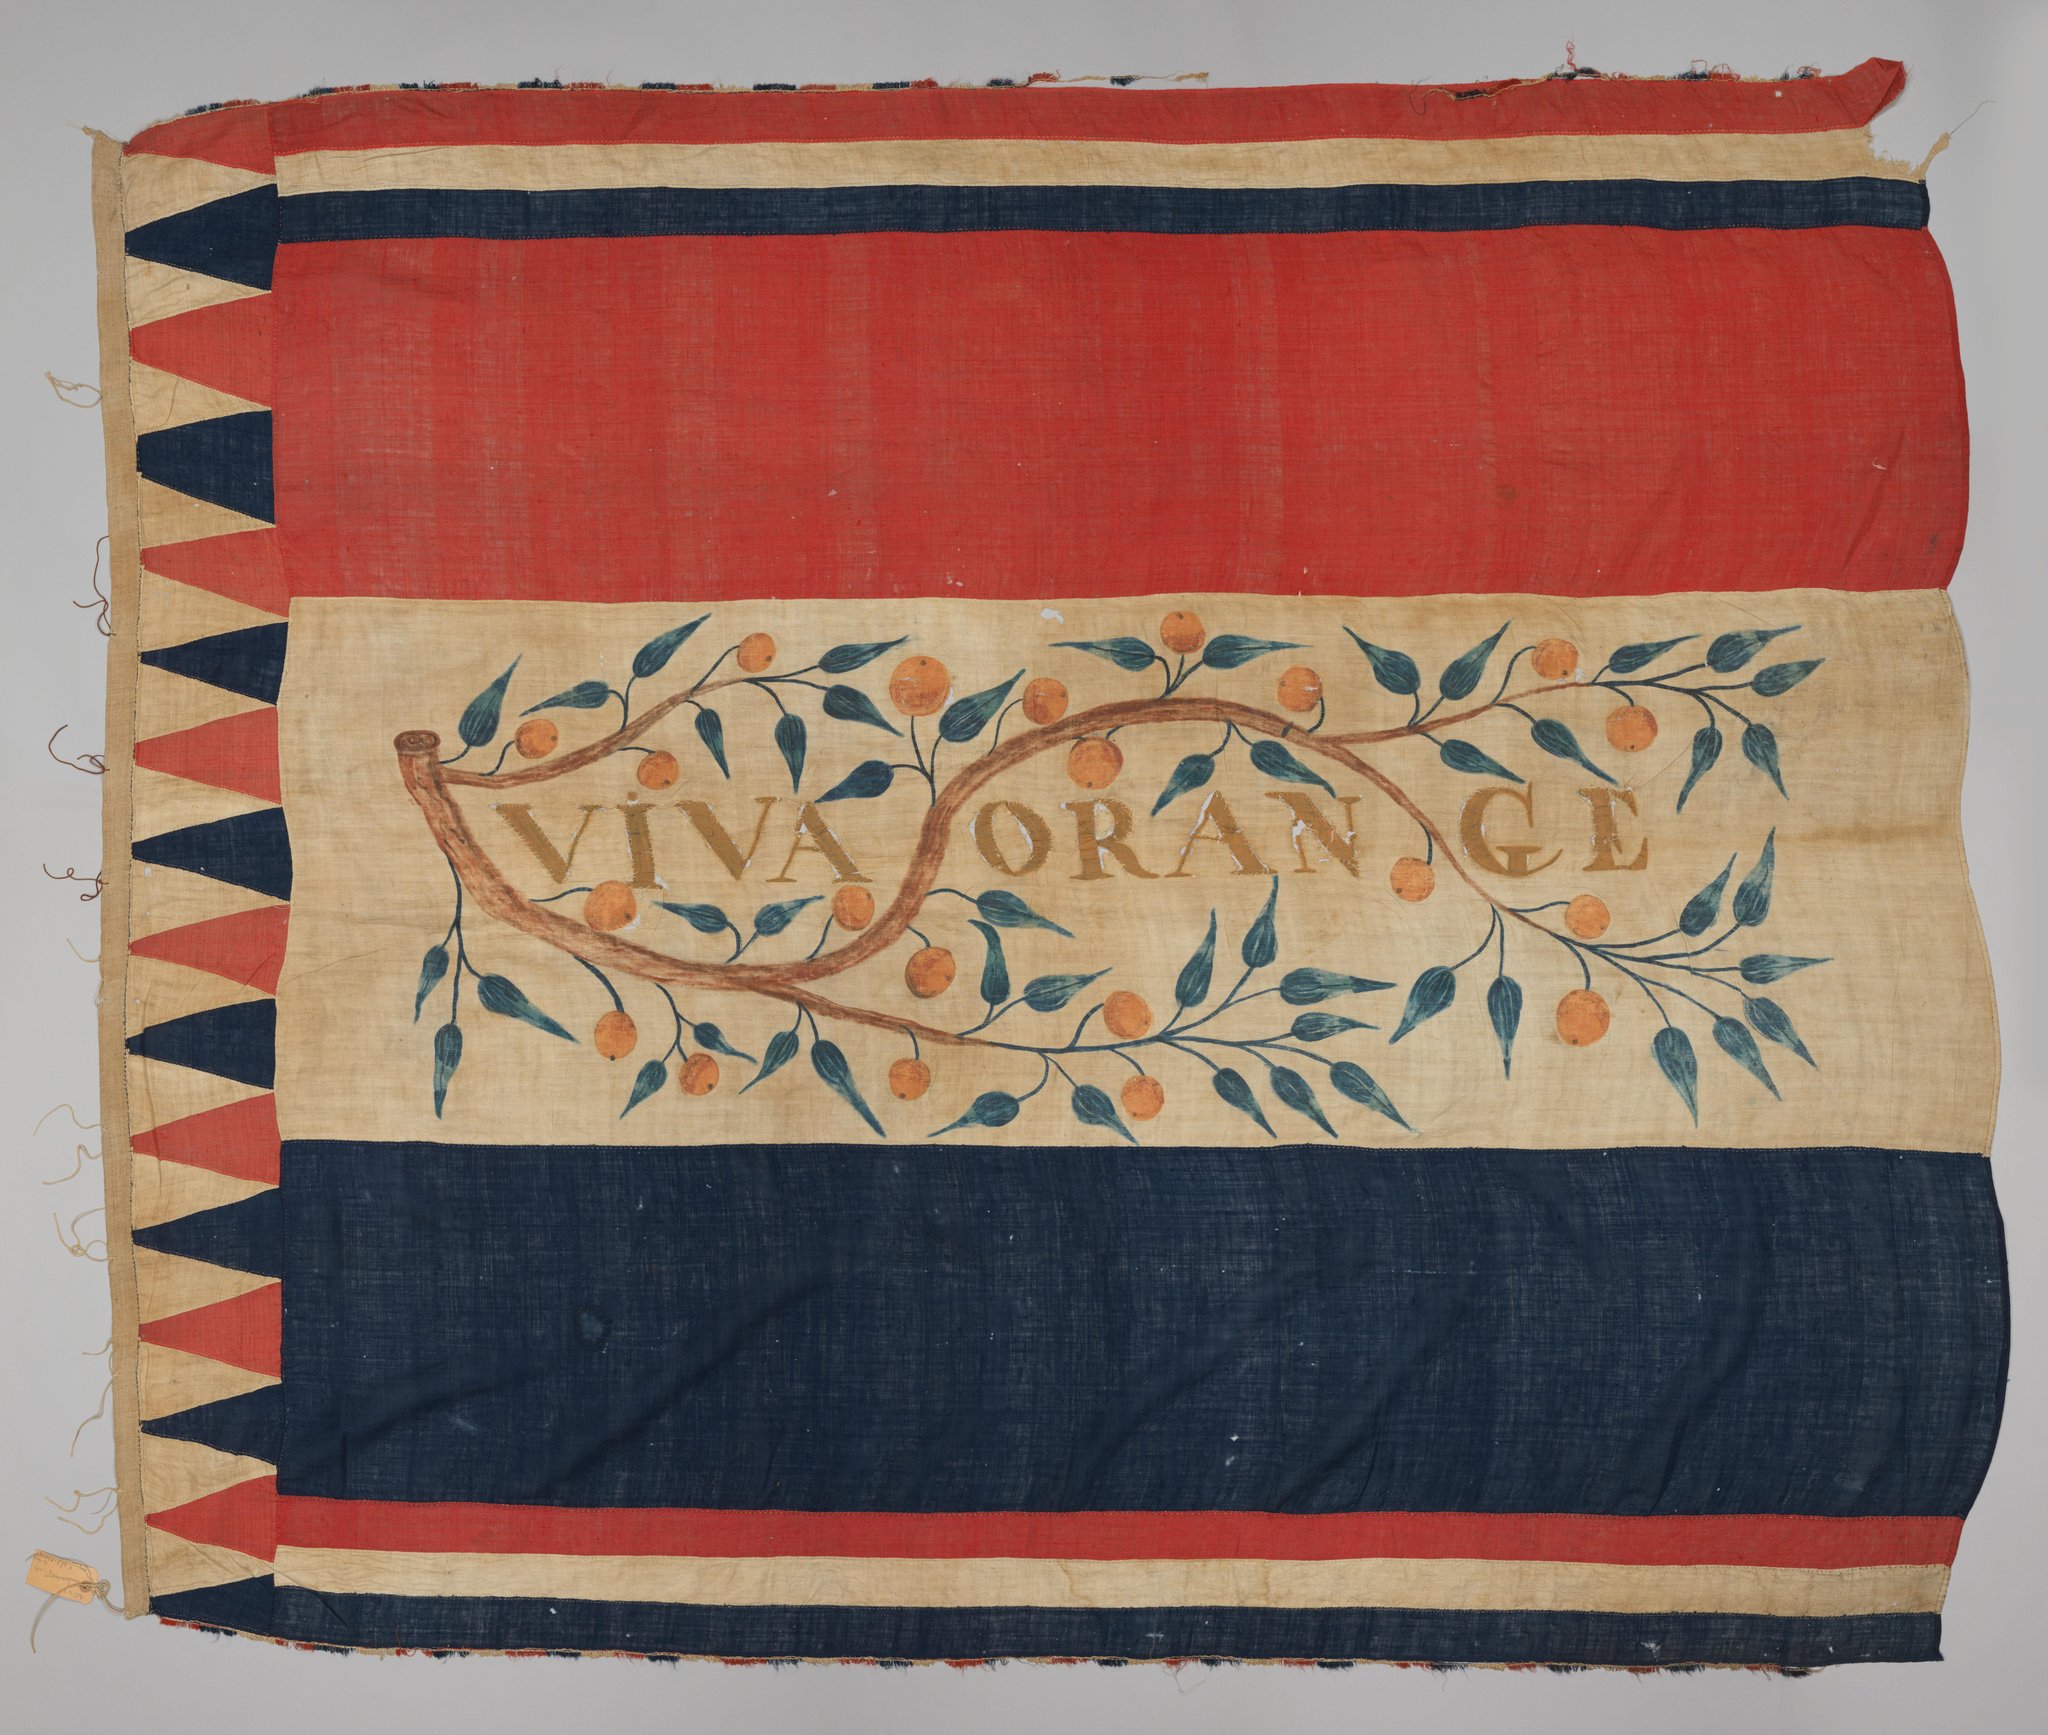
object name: flag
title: Nederlandse vlag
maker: Anonymous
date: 1787-1795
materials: cotton, paint, wool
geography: netherlands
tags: netherlands